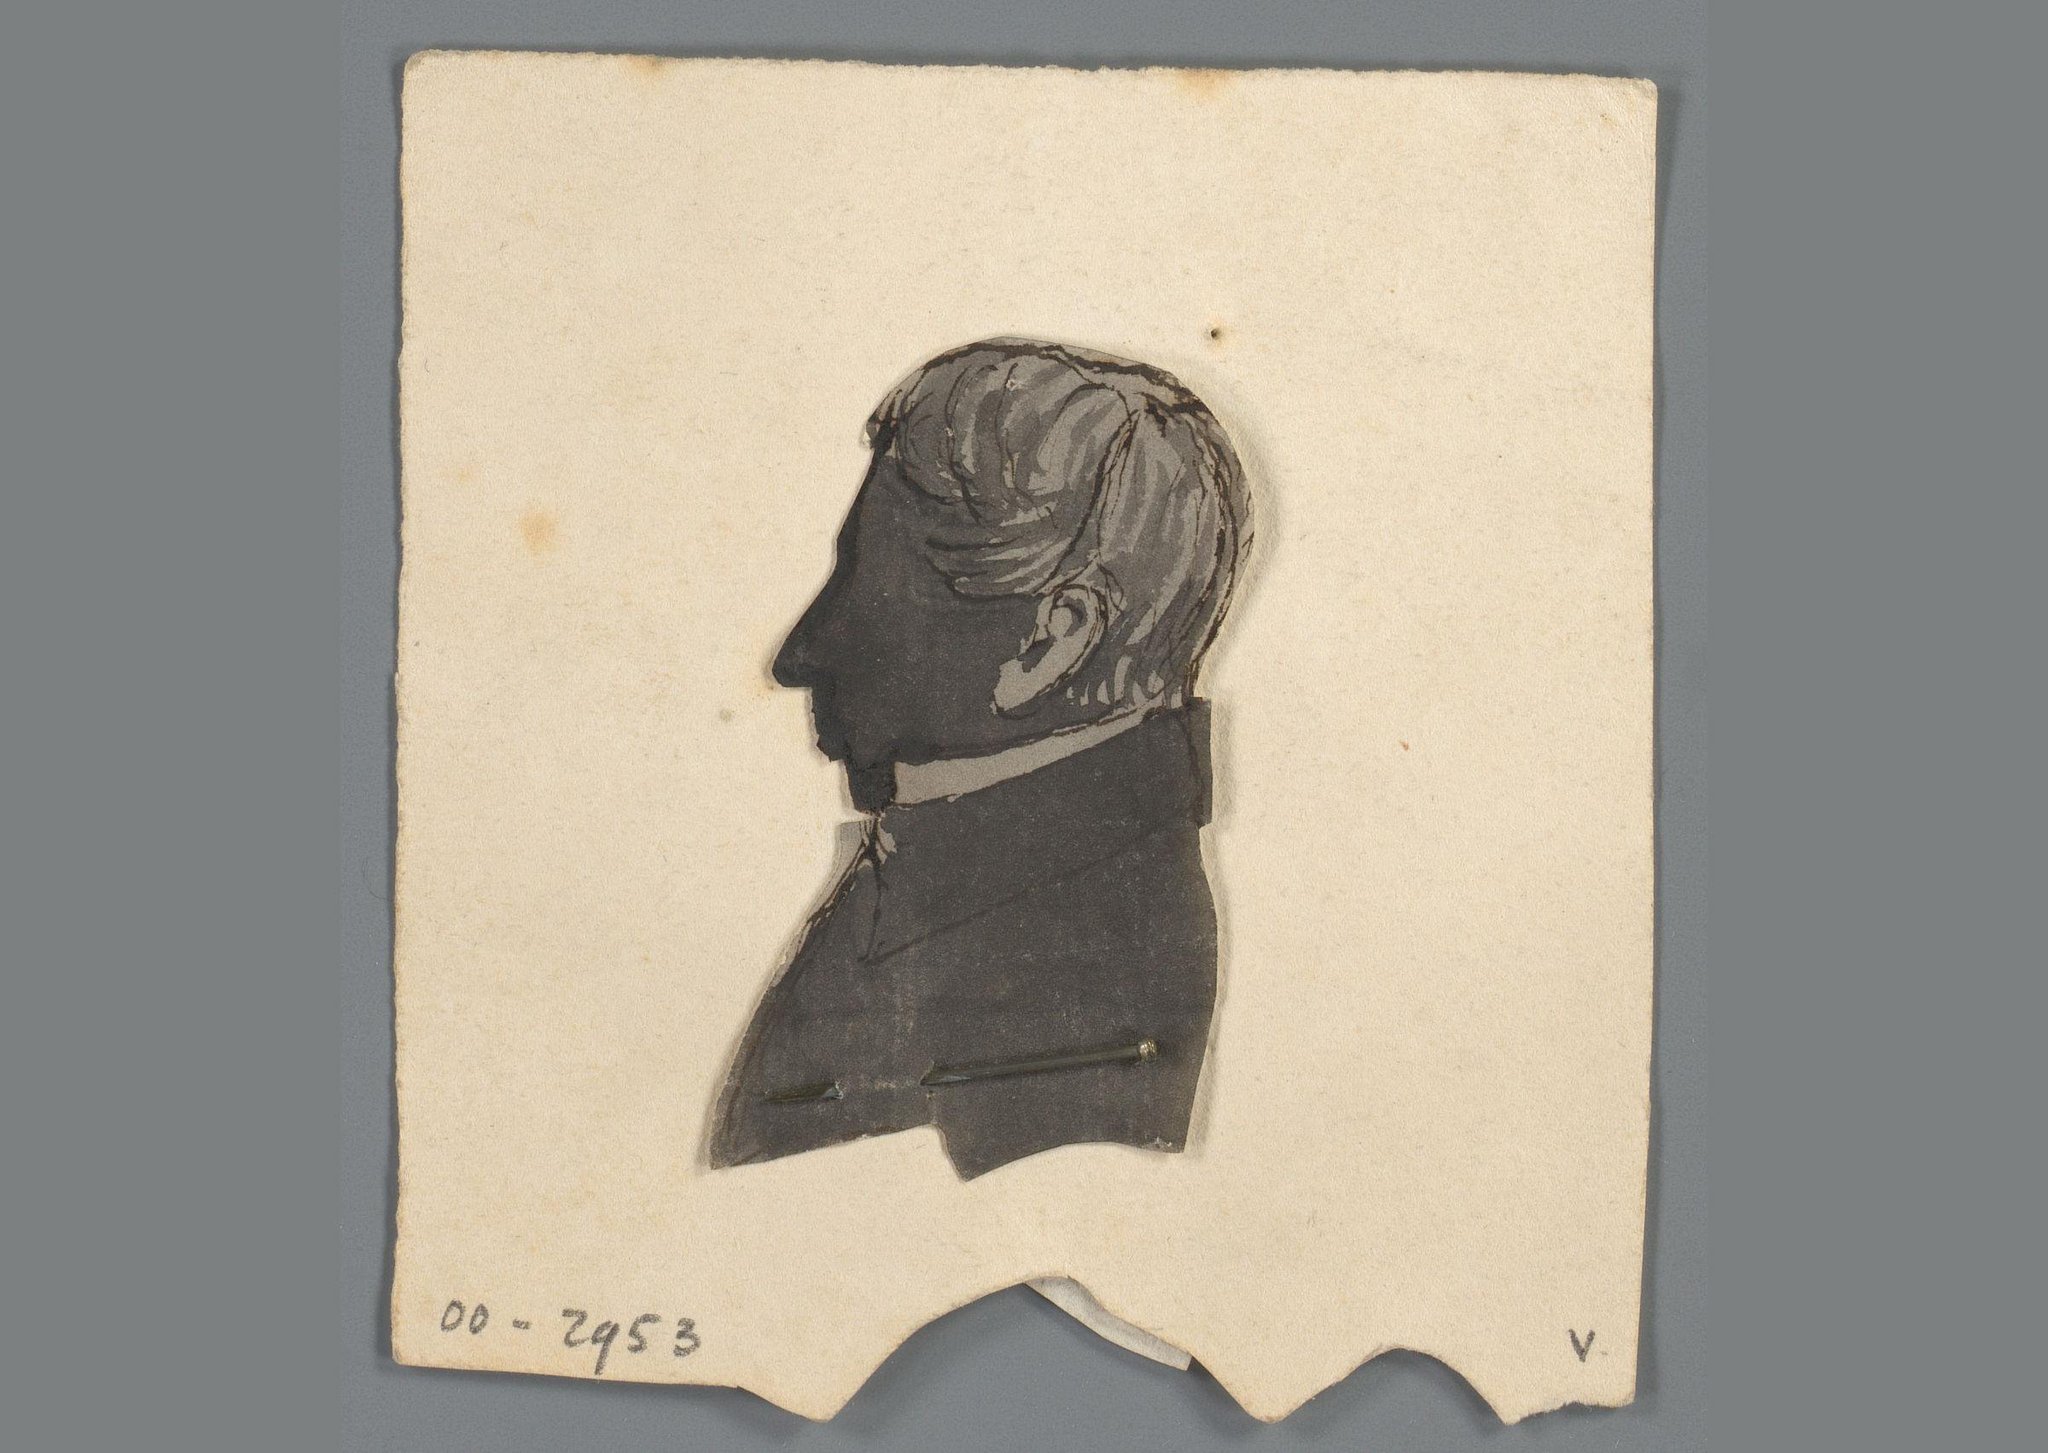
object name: cut paper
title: Silhouet van een jongeman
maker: Anonymous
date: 1700-1900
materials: ink, paper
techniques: brush, pen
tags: anonymous historical person portrayed alone, male sex; man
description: Silhouet van een jongeman, vastgespeld samen met een ander silhouet op verso op een papiertje, met tekst: Ds. C.A.L. Exalto d'Almaras.